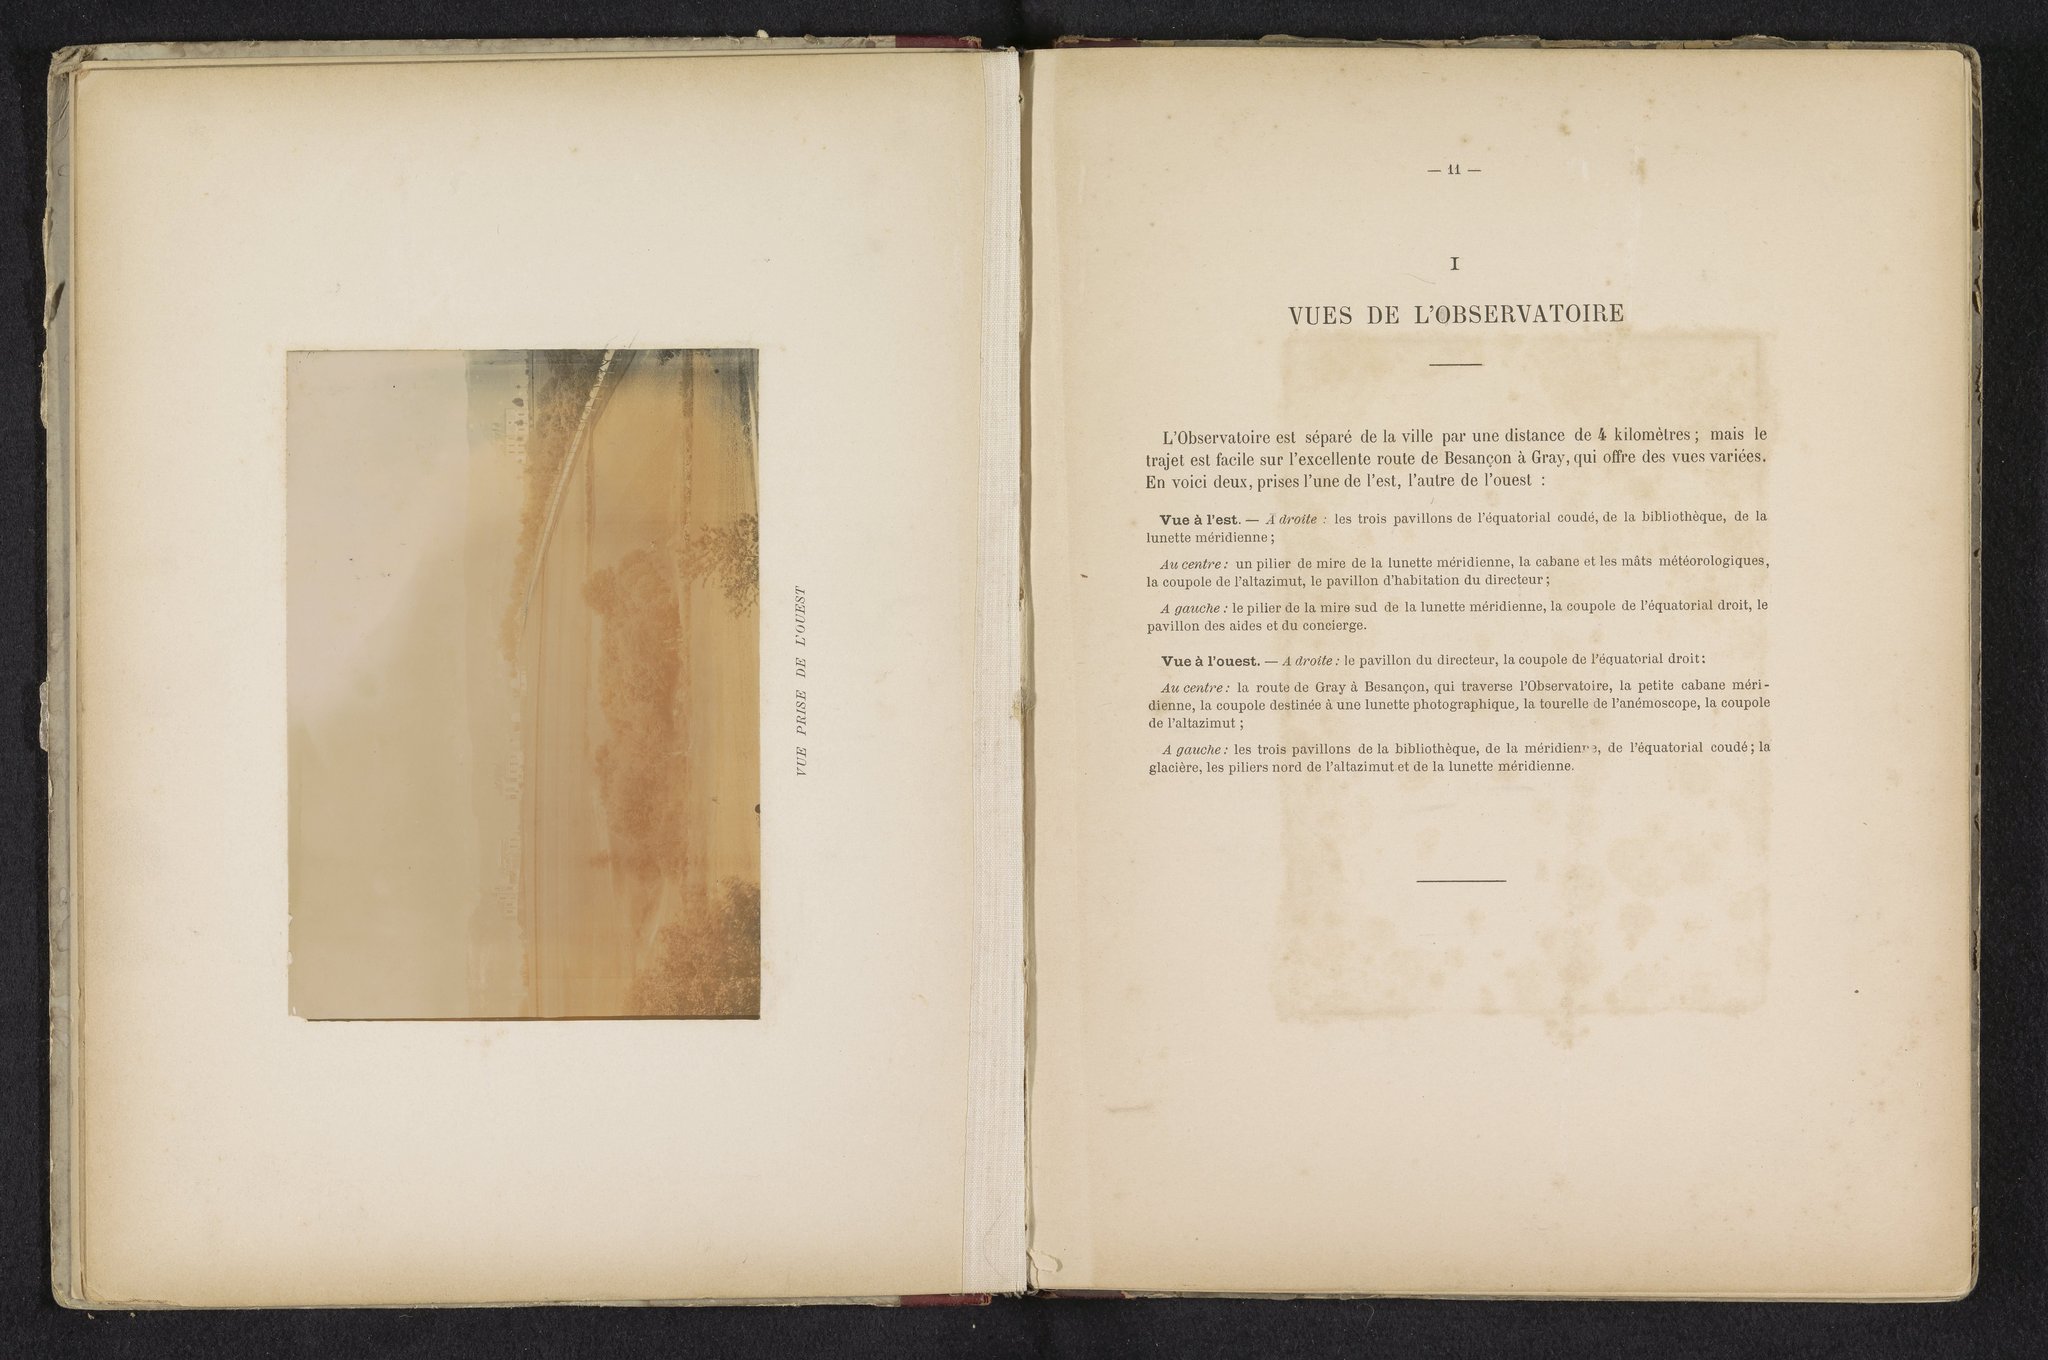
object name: page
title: Gezicht op het observatorium in Besançon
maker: m. lebeuf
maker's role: fotograaf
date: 1882-1892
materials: photographic support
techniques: gelatin silver print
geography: besançon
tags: observatory (~ astronomy), meteorological observatory